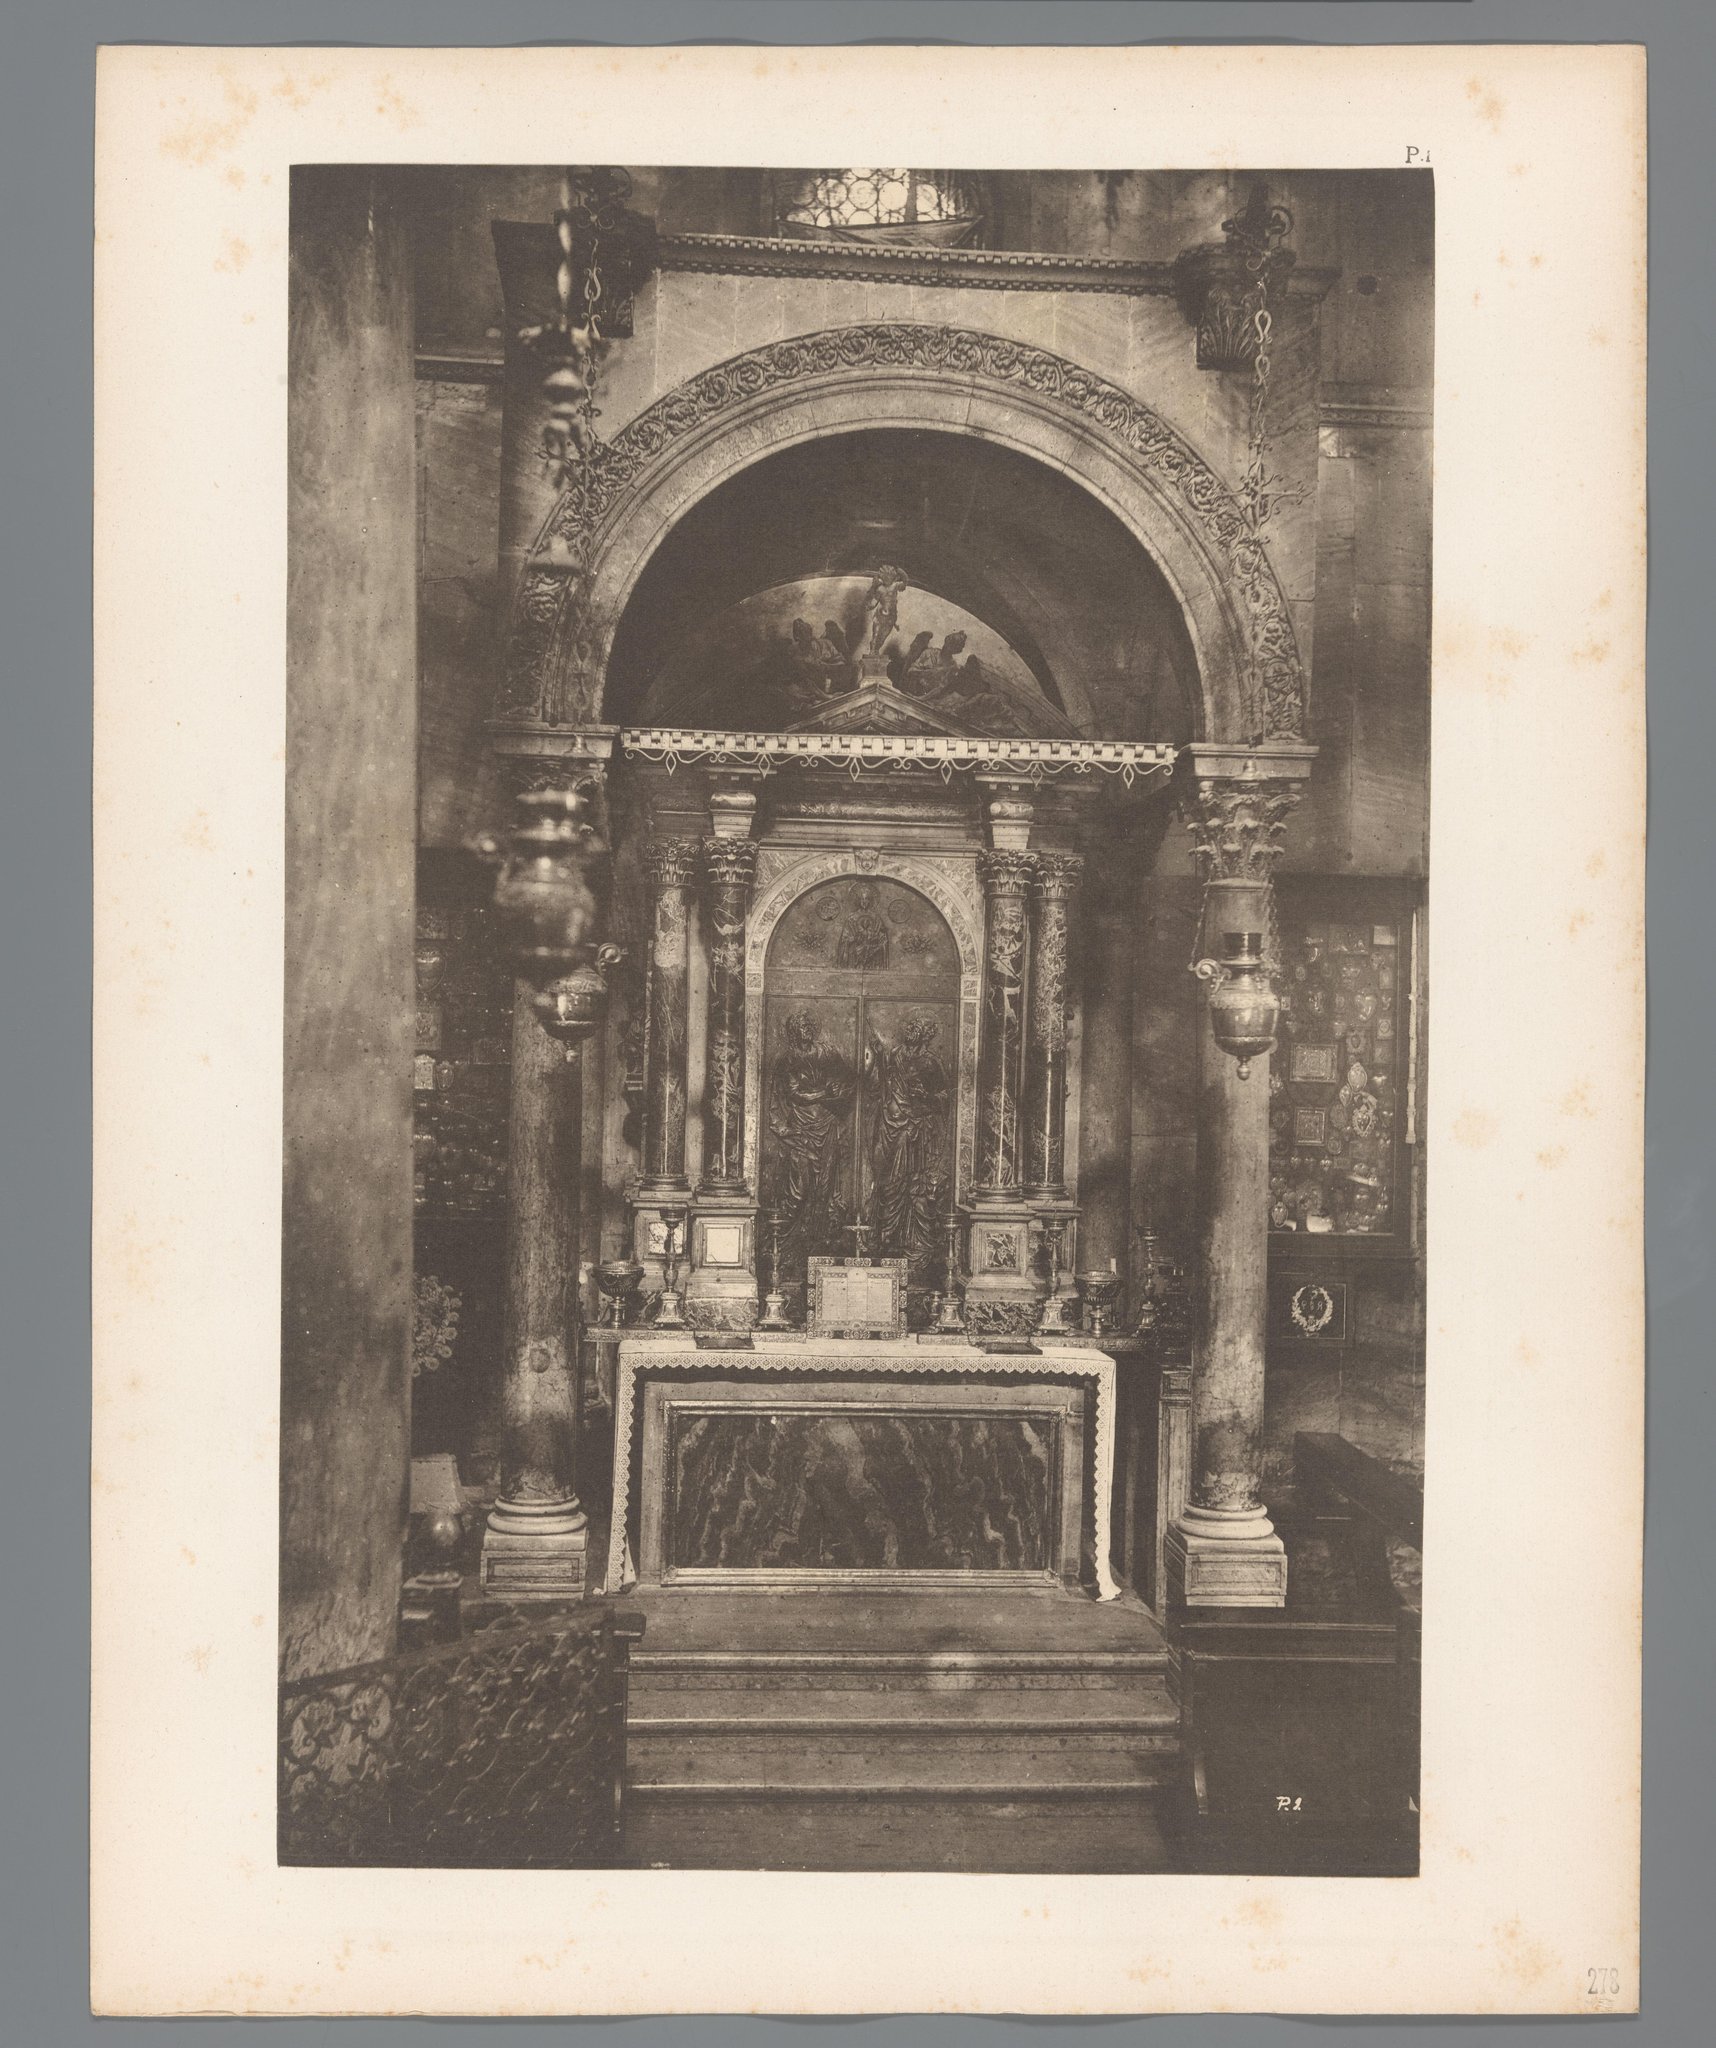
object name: photomechanical print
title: Altaar in de San Marco in Venetië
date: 1880-1885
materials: paper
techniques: photograph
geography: st. mark's basilica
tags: interior of church, fixed altar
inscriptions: number: ‘P.I’, number: ‘P.1.’, number: ‘278’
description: Deze prent maakt deel uit van een omslag met 58 prenten op 50 bladen.